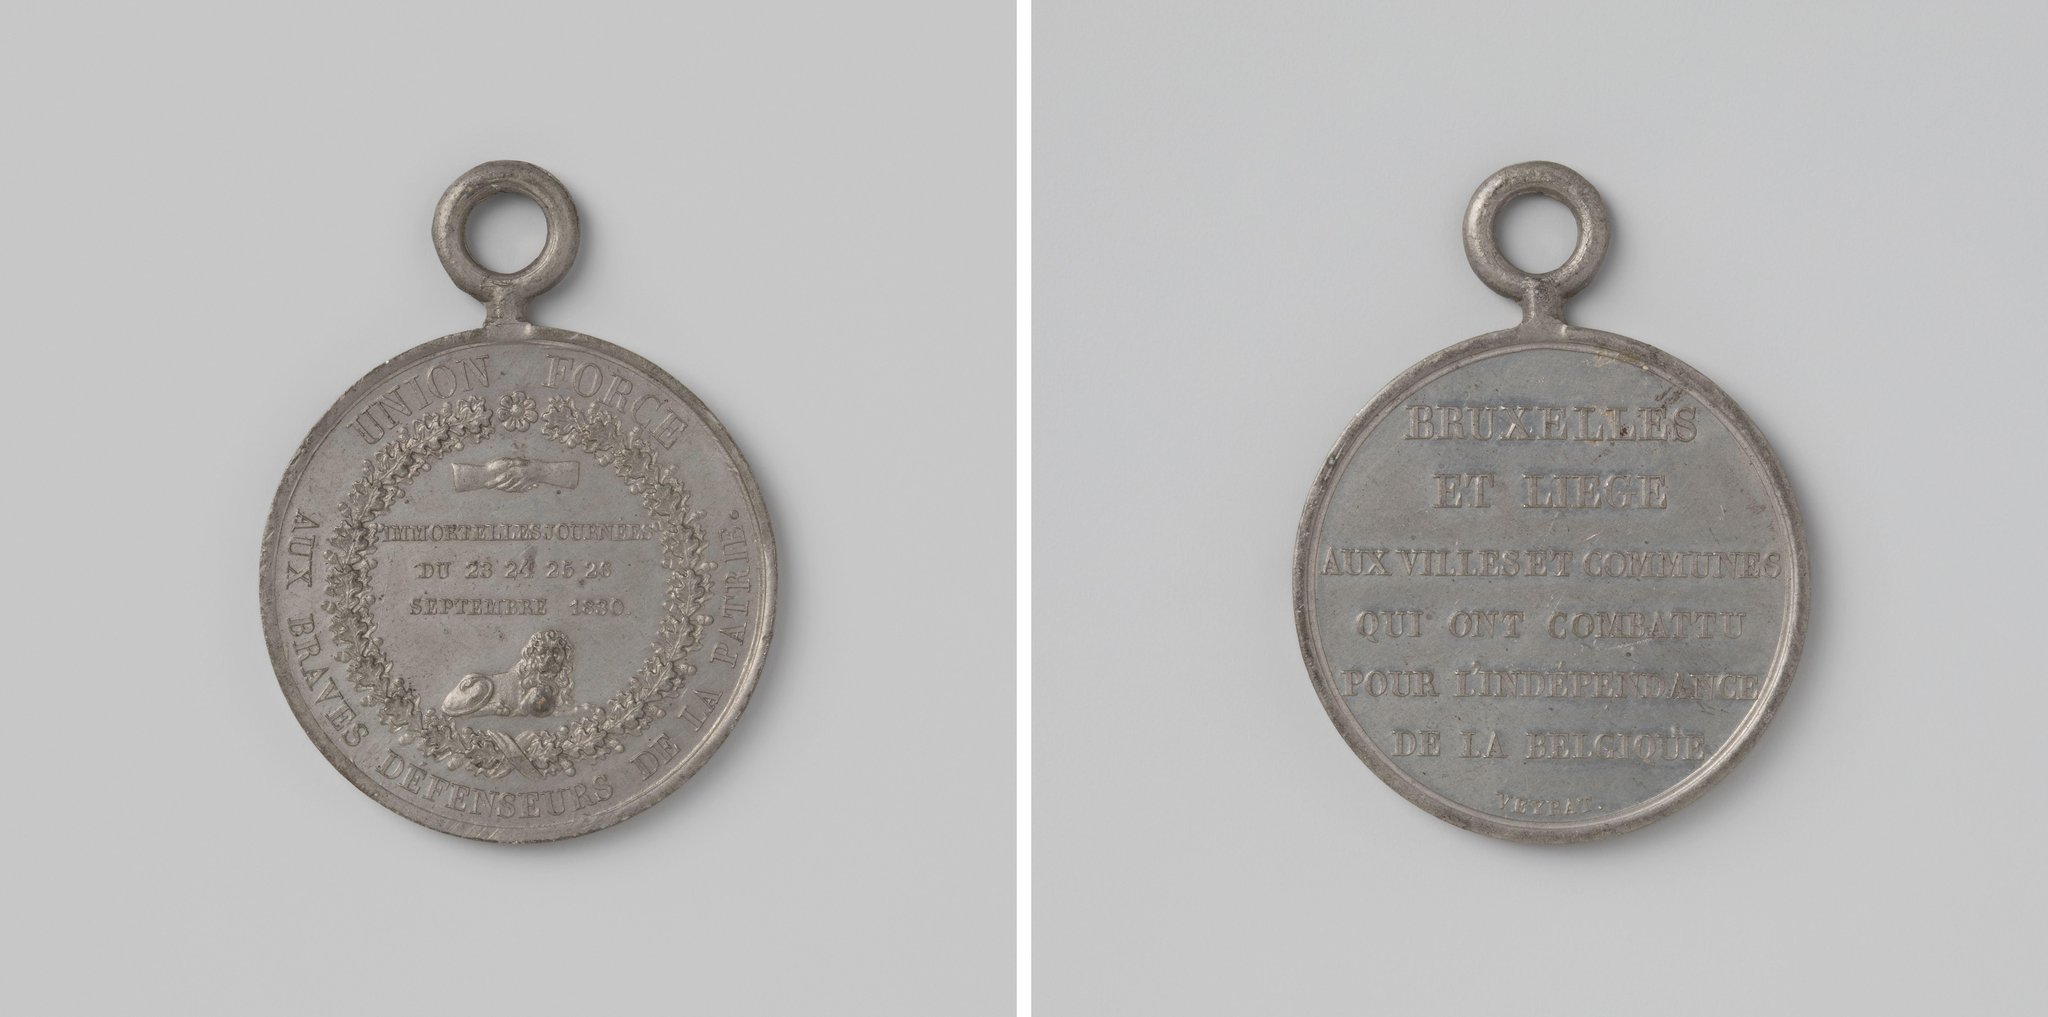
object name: insignia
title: Septemberdagen te Brussel en Luik, ter ere van degenen die voor de onafhankelijkheid van het vaderland hebben gevochten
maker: adrien hippolyte veyrat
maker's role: medailleur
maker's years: 1803-1883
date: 1830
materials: alloy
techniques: striking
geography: brussels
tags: liège, brussels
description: Draagteken aan draagoog en zwart-geel-rood lint. Voorzijde: opschrift onder twee ineen geslagen handen, boven liggende leeuw binnen eikenkrans en omschrift. Keerzijde: opschrift.